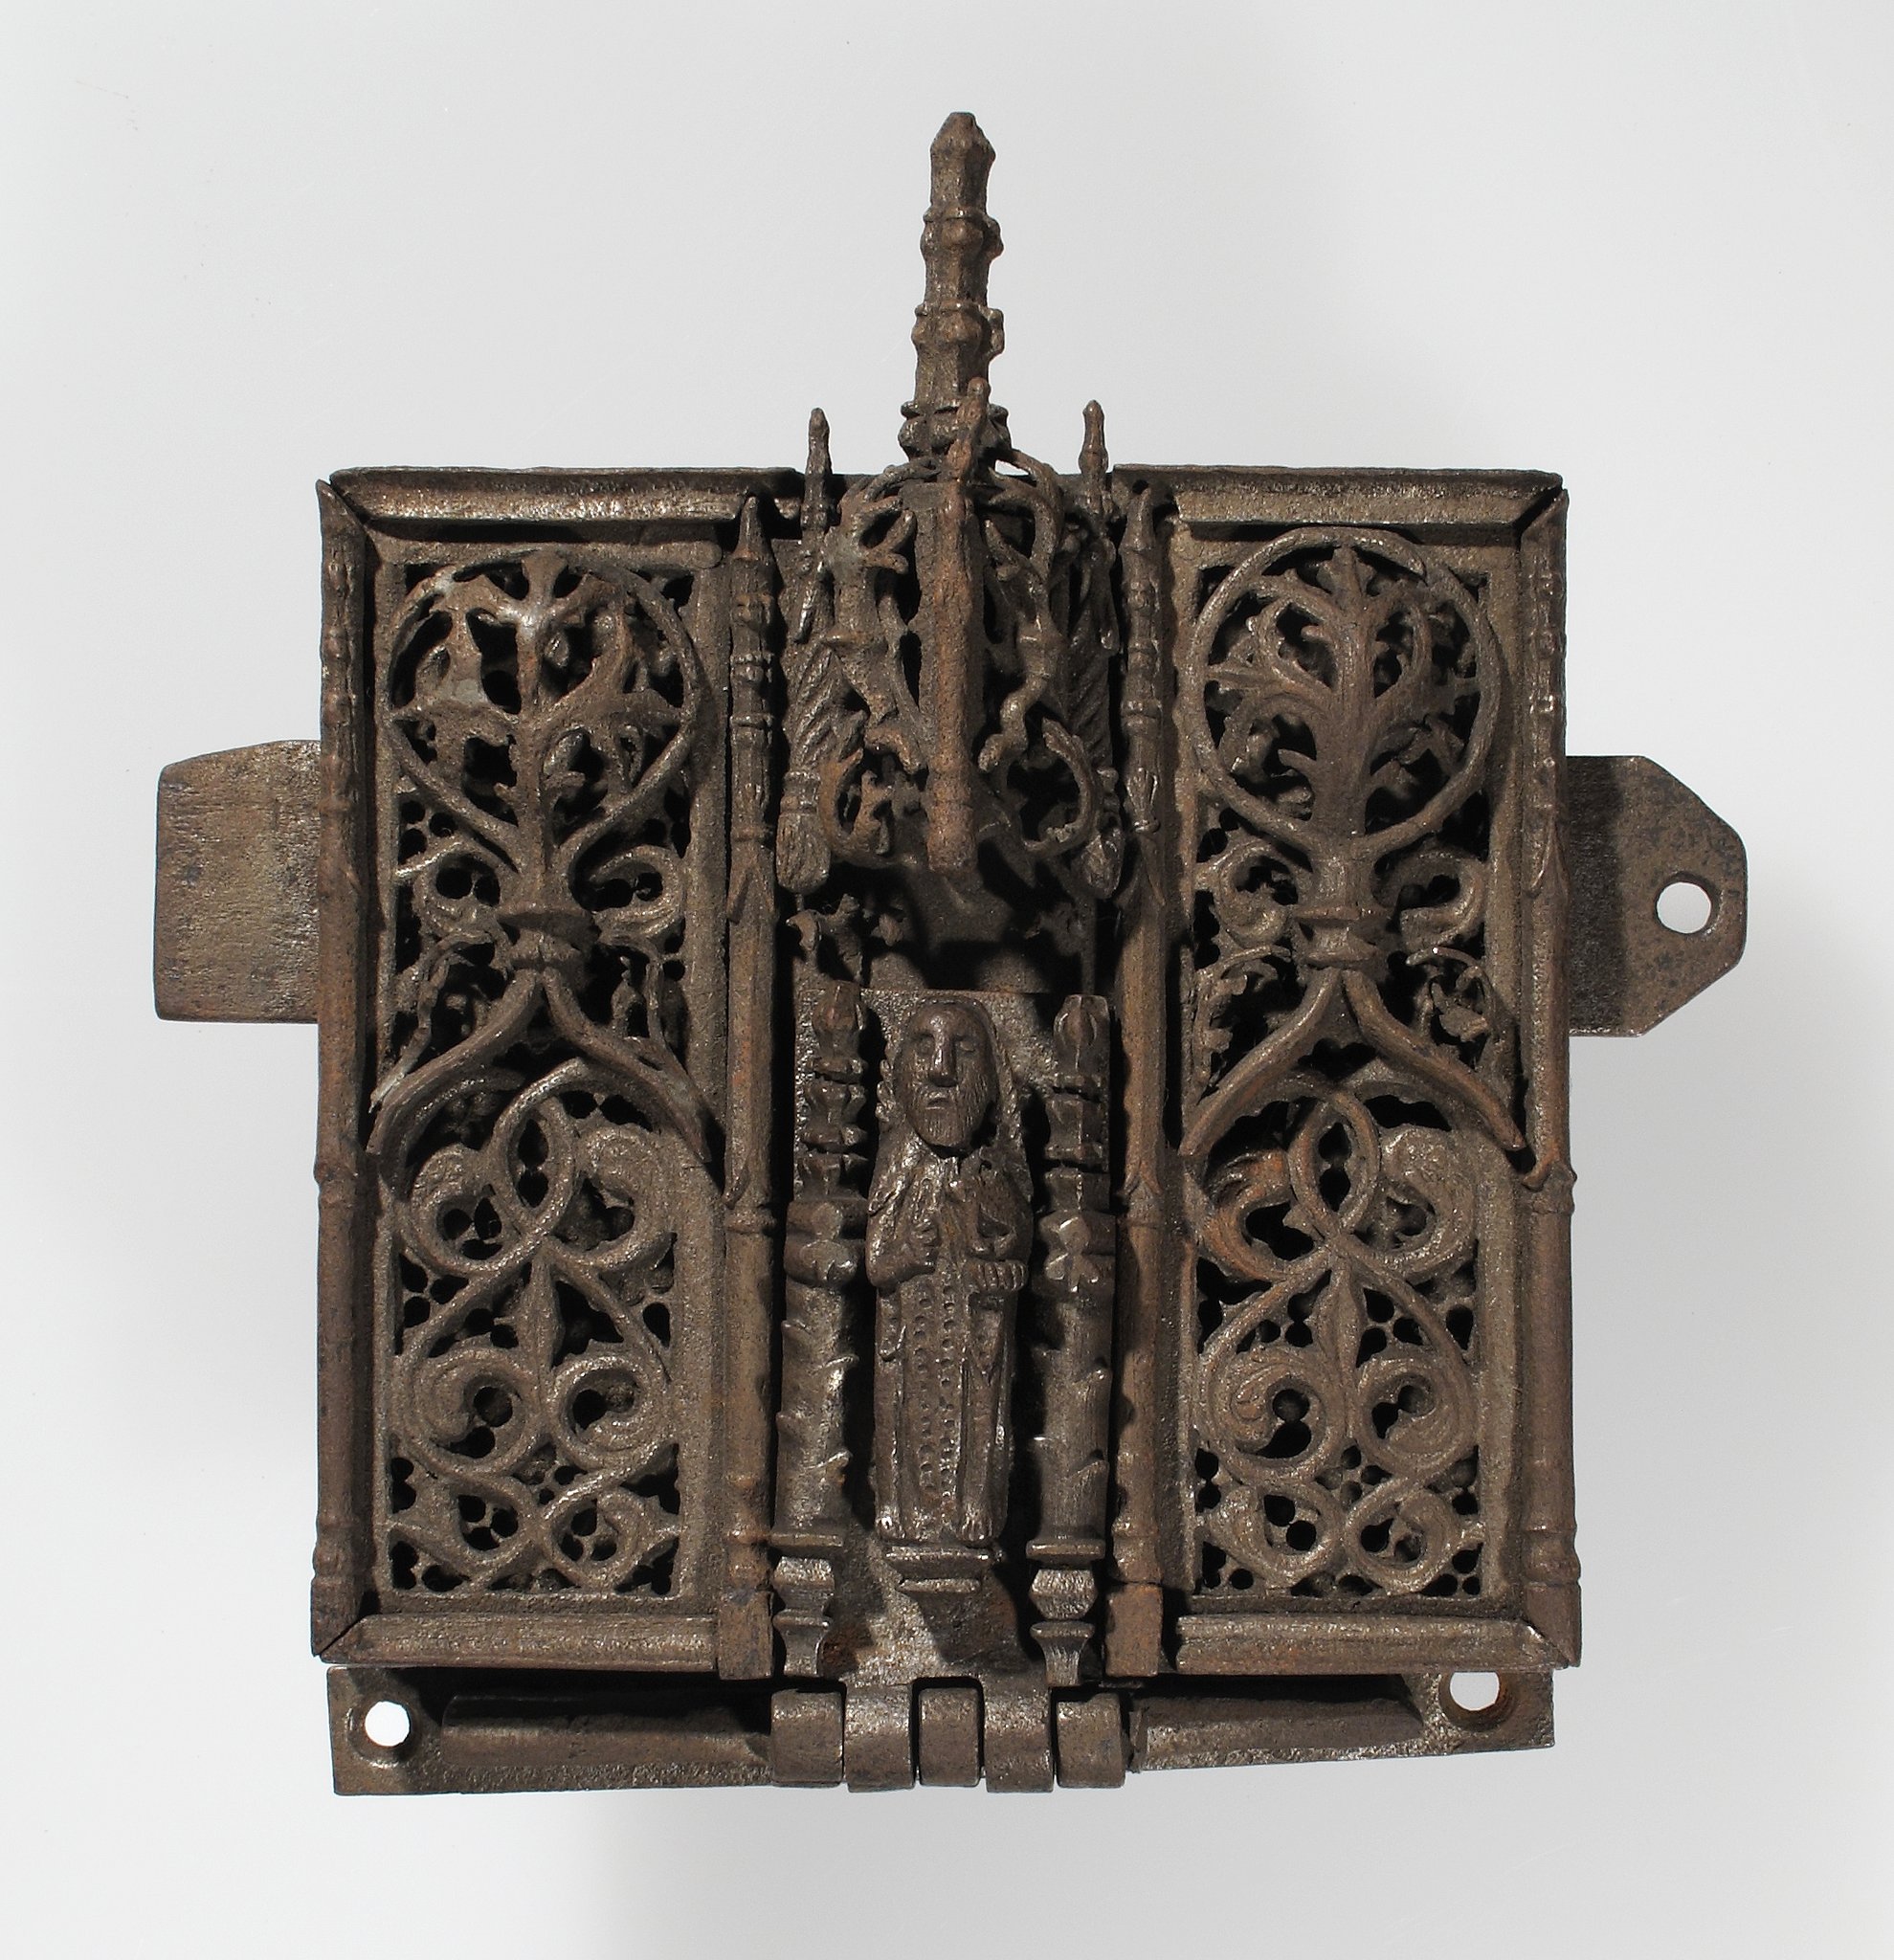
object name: lock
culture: european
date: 1401-1600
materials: iron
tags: saint john the baptist